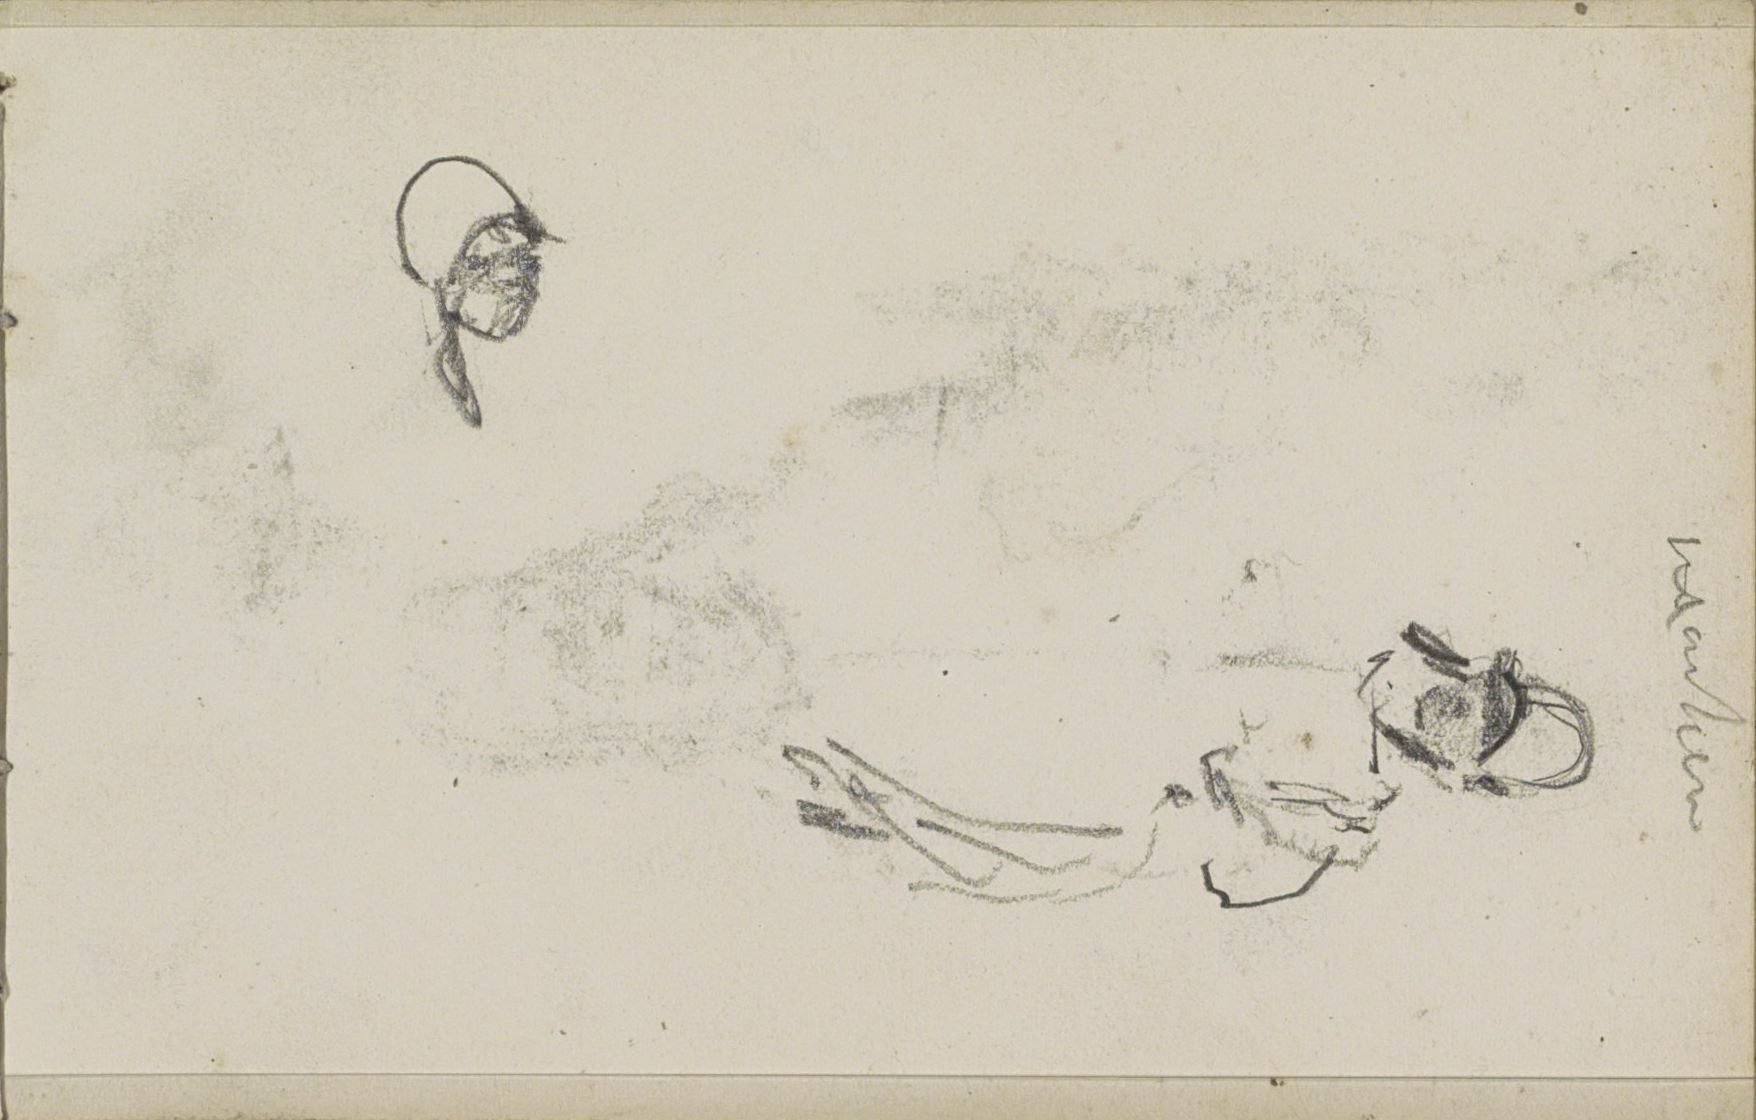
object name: sketchbook leaf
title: Koppen van figuren in Marker klederdracht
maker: george clausen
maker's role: draughtsman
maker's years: 1852-1912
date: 1875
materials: paper, pencil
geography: marken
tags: head-gear: cap (+ women's clothes), folk costume, regional costume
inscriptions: annotation: ‘marken’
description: Blad 26 recto uit een schetsboek met 38 bladen.